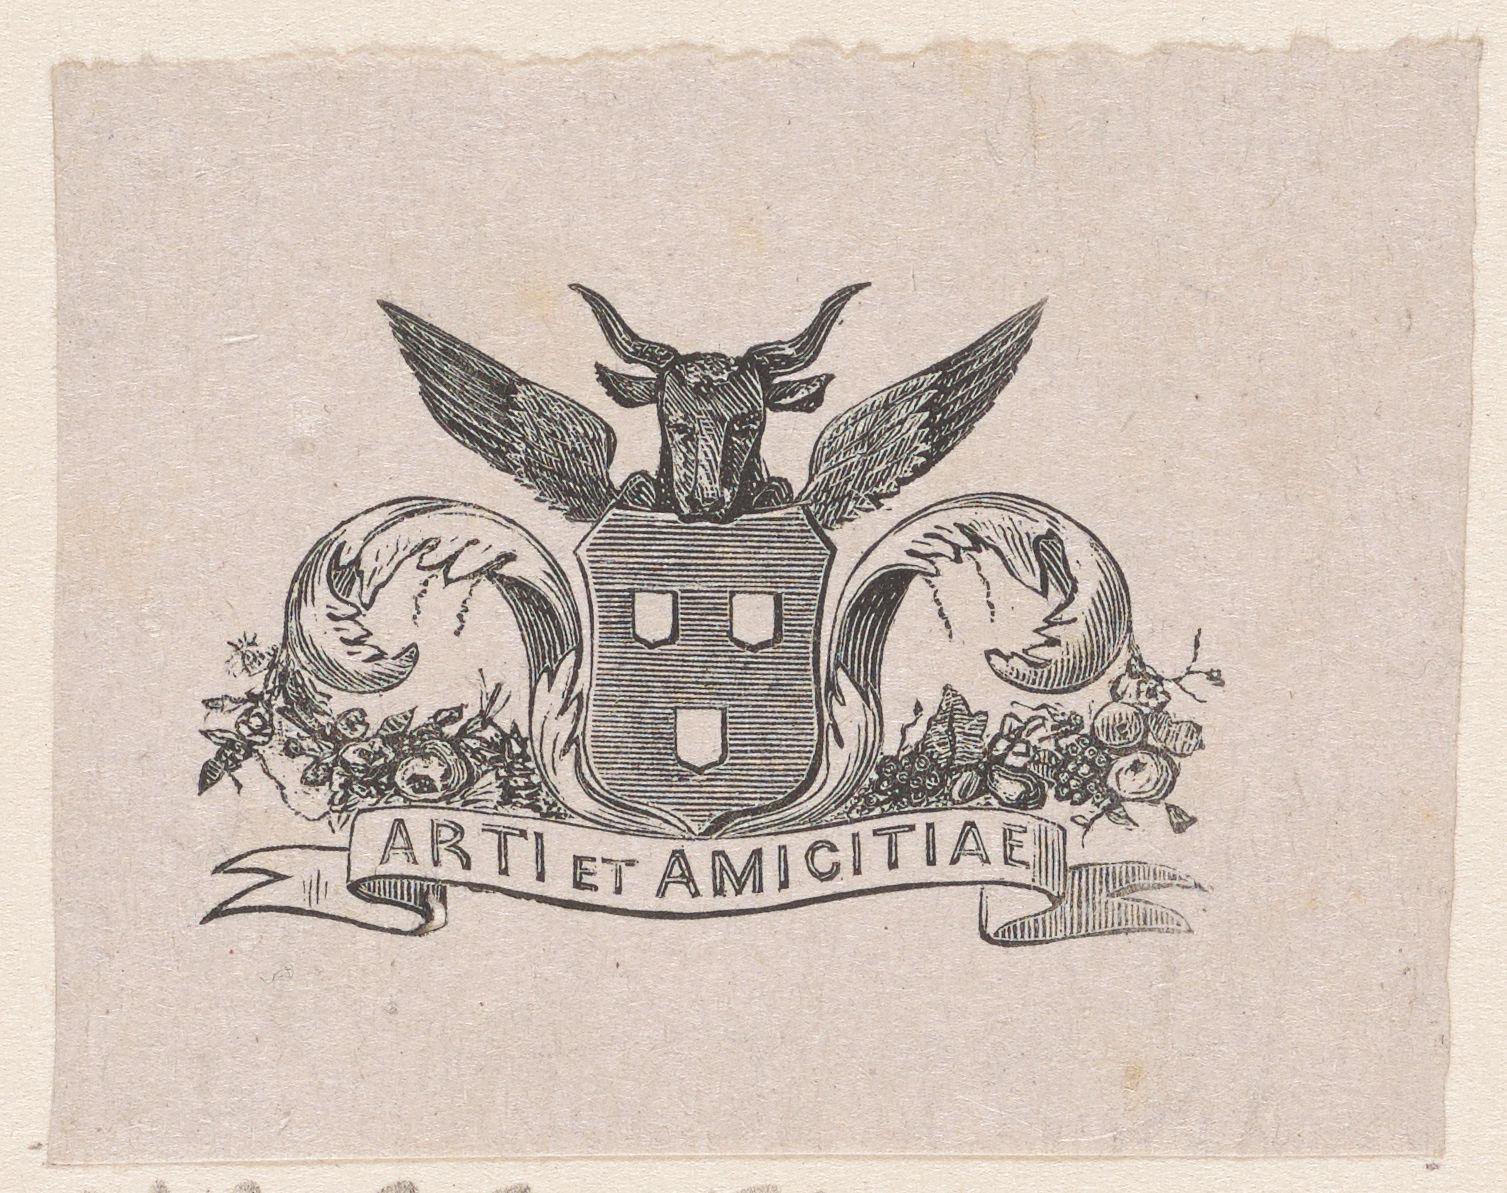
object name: print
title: Vignet van kunstenaarsvereniging 'Arti et amicitiae' te Amsterdam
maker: isaac weissenbruch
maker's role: print maker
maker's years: 1826-1912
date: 1836-1912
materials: paper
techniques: engraving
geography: netherlands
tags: coat of arms (as symbol of the state, etc.), ox (possibly with book) ~ symbol of st. luke, academy, association of artists, vignette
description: Een wapen met daarboven de gevleugelde os van Lucas de evangelist.